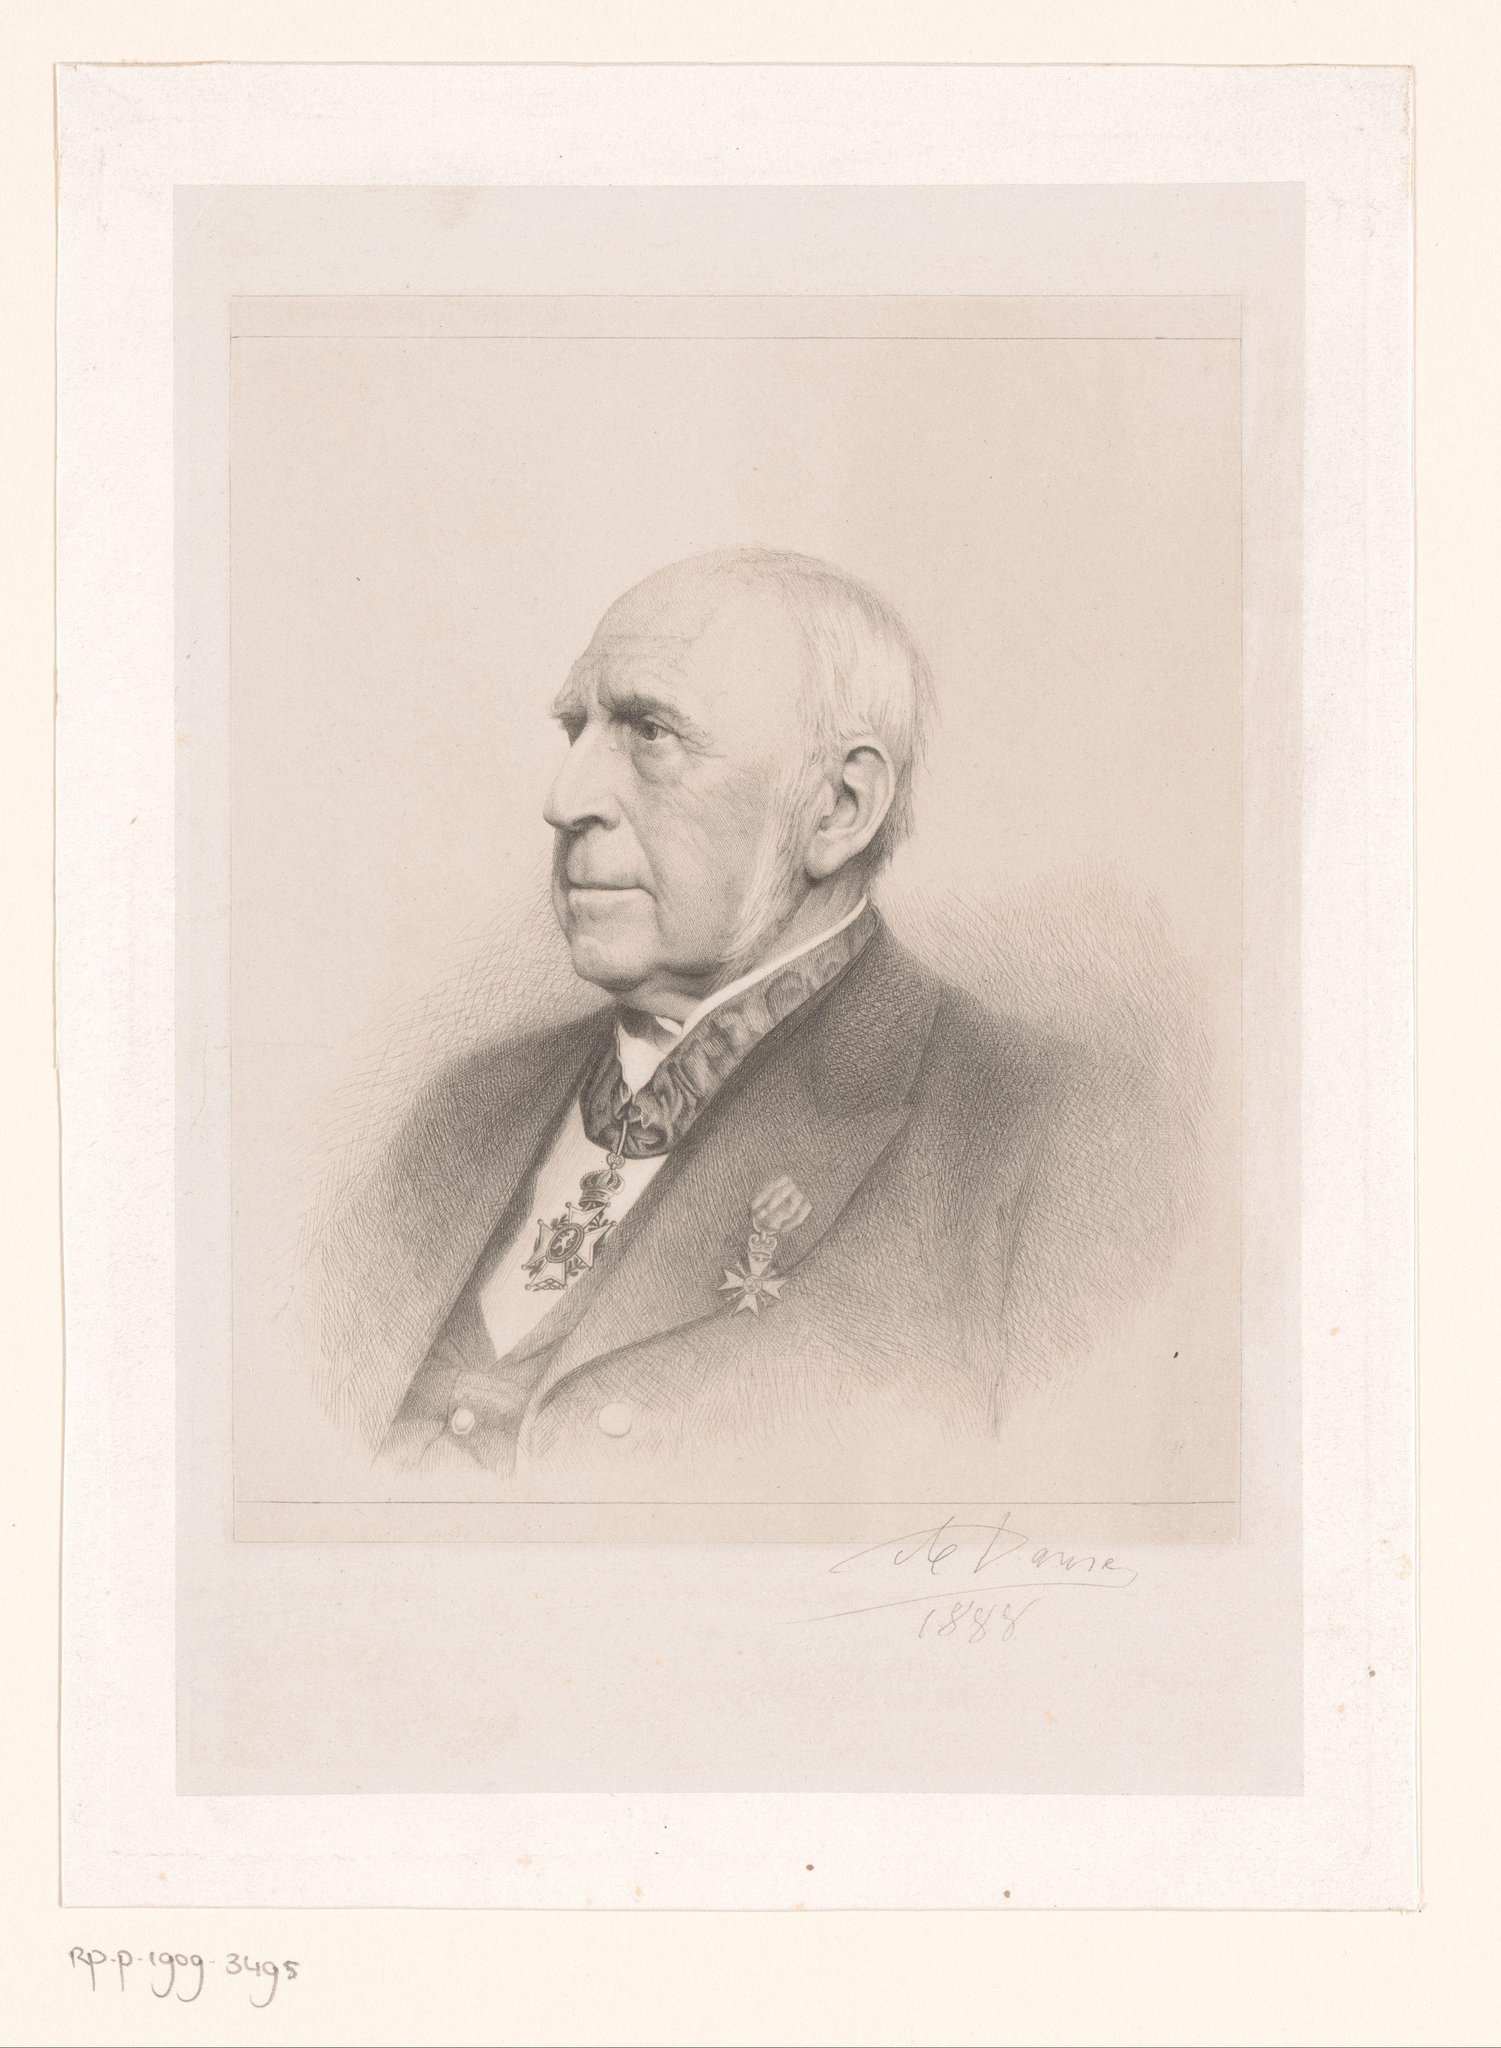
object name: print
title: Portret van een onbekende man, mogelijk Deville, directeur van de mijnbouwschool te Mons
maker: auguste danse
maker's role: print maker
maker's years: 1829-1929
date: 1888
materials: paper, pencil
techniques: etching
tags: anonymous historical person portrayed alone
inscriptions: collector's mark: Lugt 2228